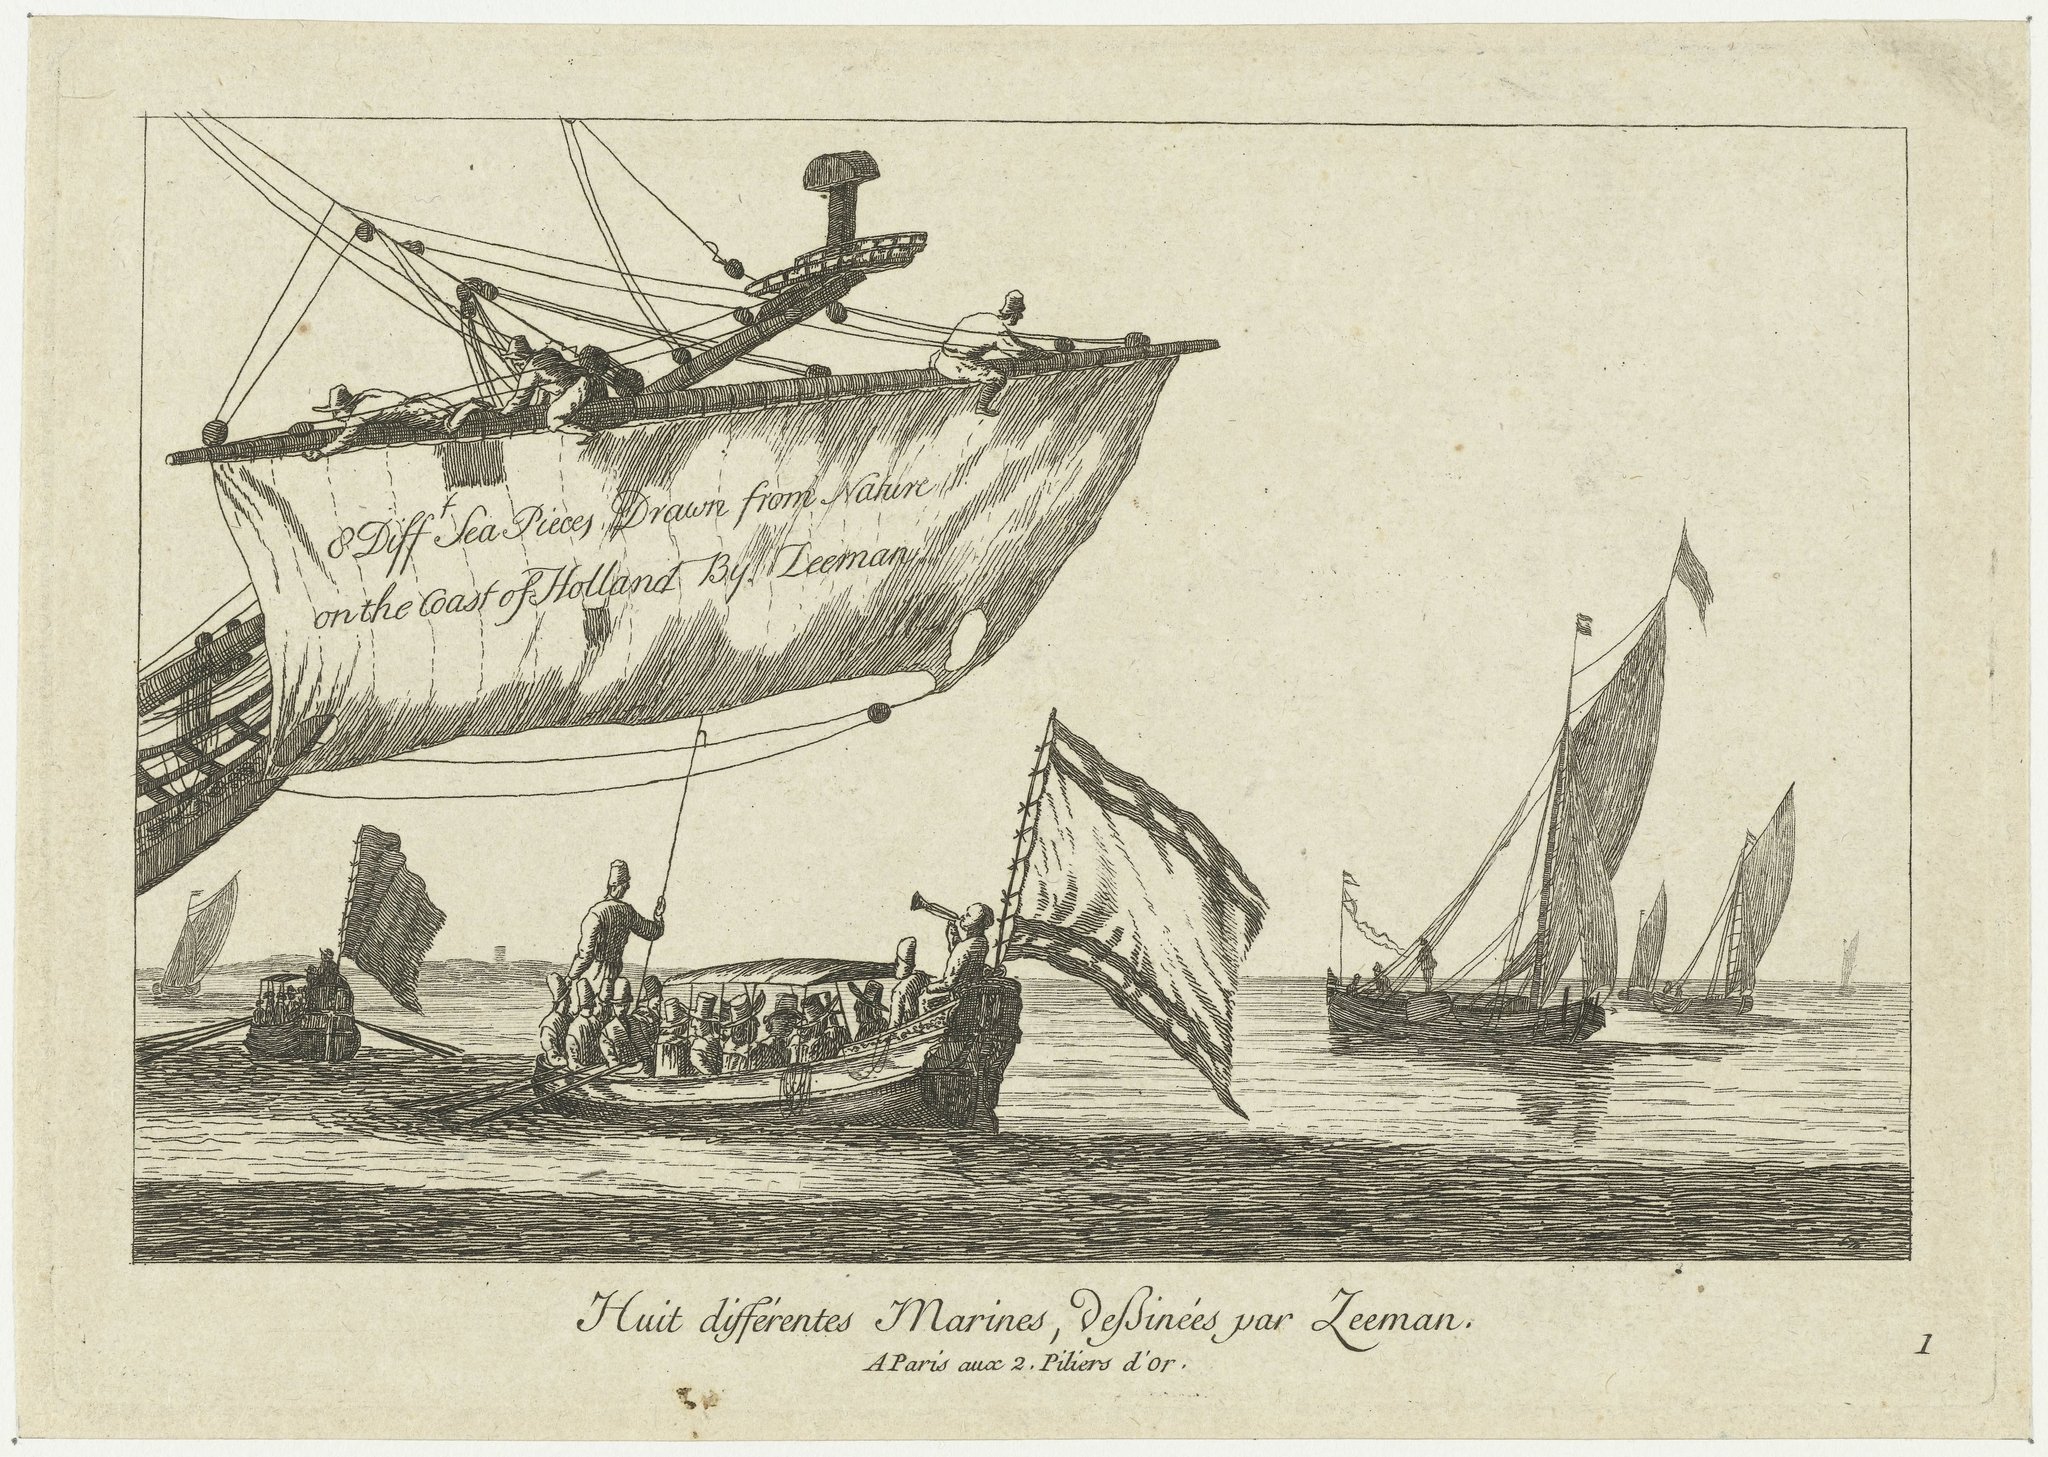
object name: titelprent, frontispice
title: Huit différentes Marines, dessinées par Zeeman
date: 1700-1799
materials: paper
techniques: etching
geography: paris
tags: sailing-ship, sailing-boat, parts of ship's exterior: bow, rowing-boat, canoe, etc.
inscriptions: collector's mark: Lugt 2228a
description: Titelblad van een serie van acht kopieën. Twee statensloepen, gebruikt op hooggeplaatste figuren te vervoeren, met een baldakijn en een vlag. Een aantal zeilschepen en de boegspriet van een groter zeilschip met een zeil met tekst, drie mannen op de ra.